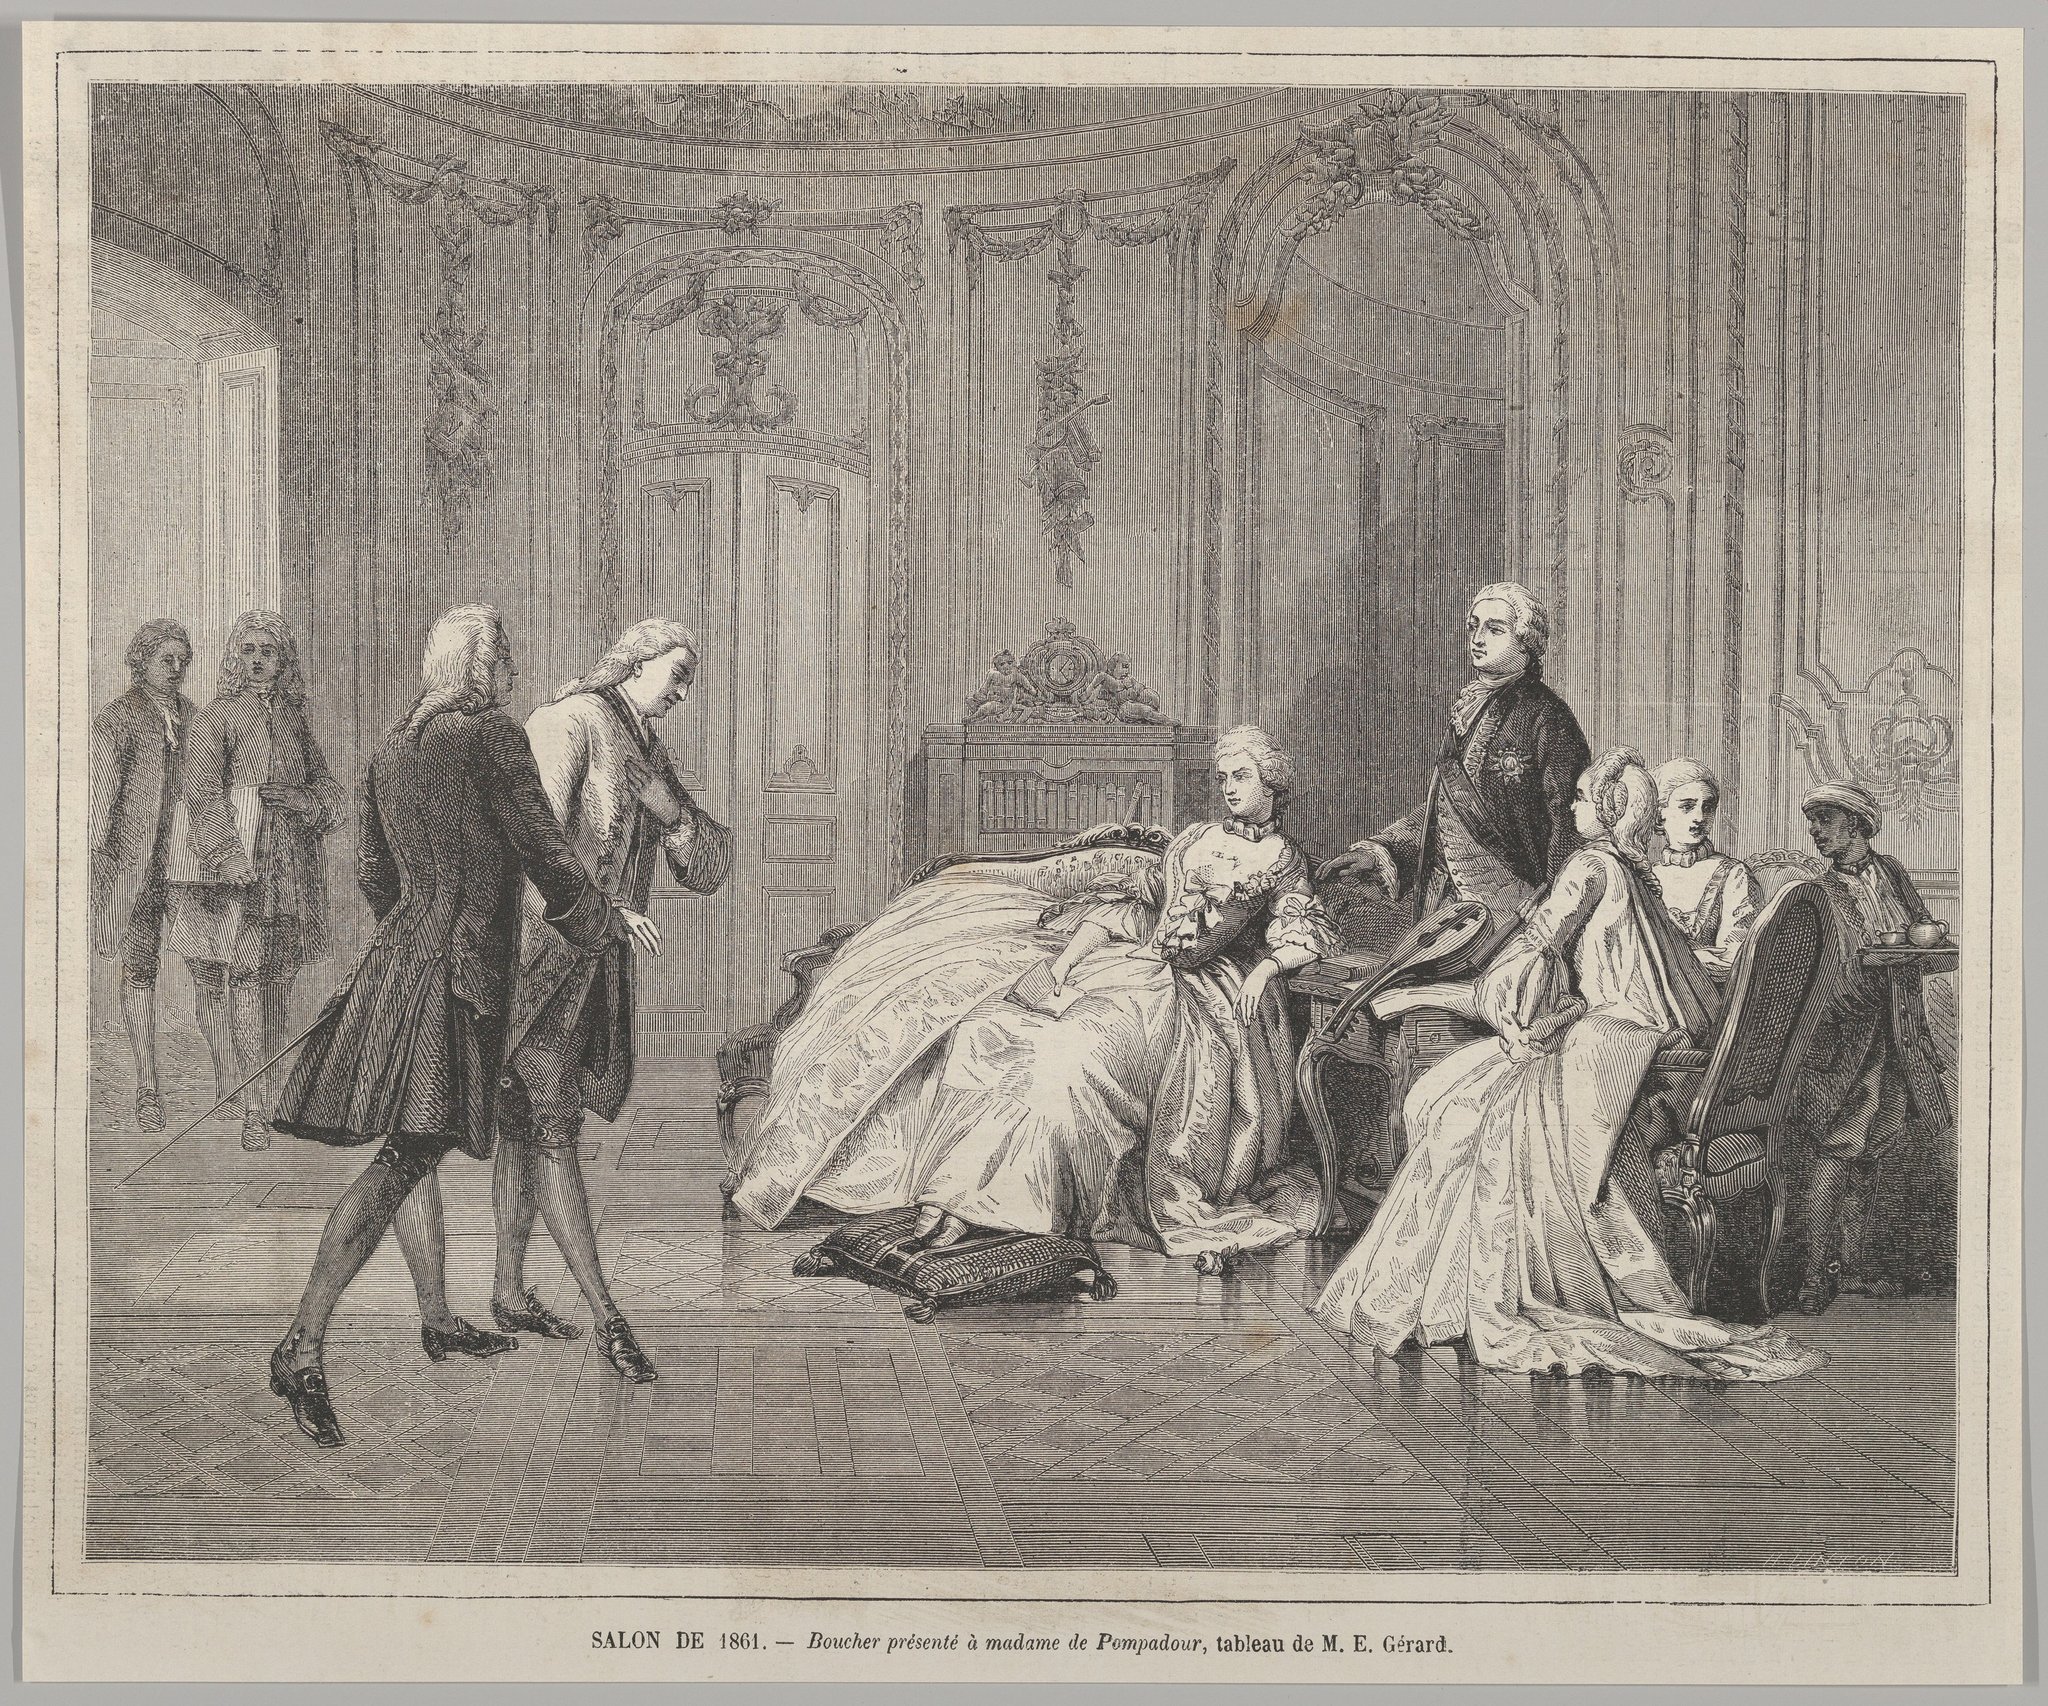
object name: print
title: Boucher présenté à Madame de Pompadour (Boucher presented to Madame de Pompadour), from "Le Monde Illustré"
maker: henry linton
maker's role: engraver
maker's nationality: british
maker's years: 1815-1899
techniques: engraving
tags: interiors,men,women